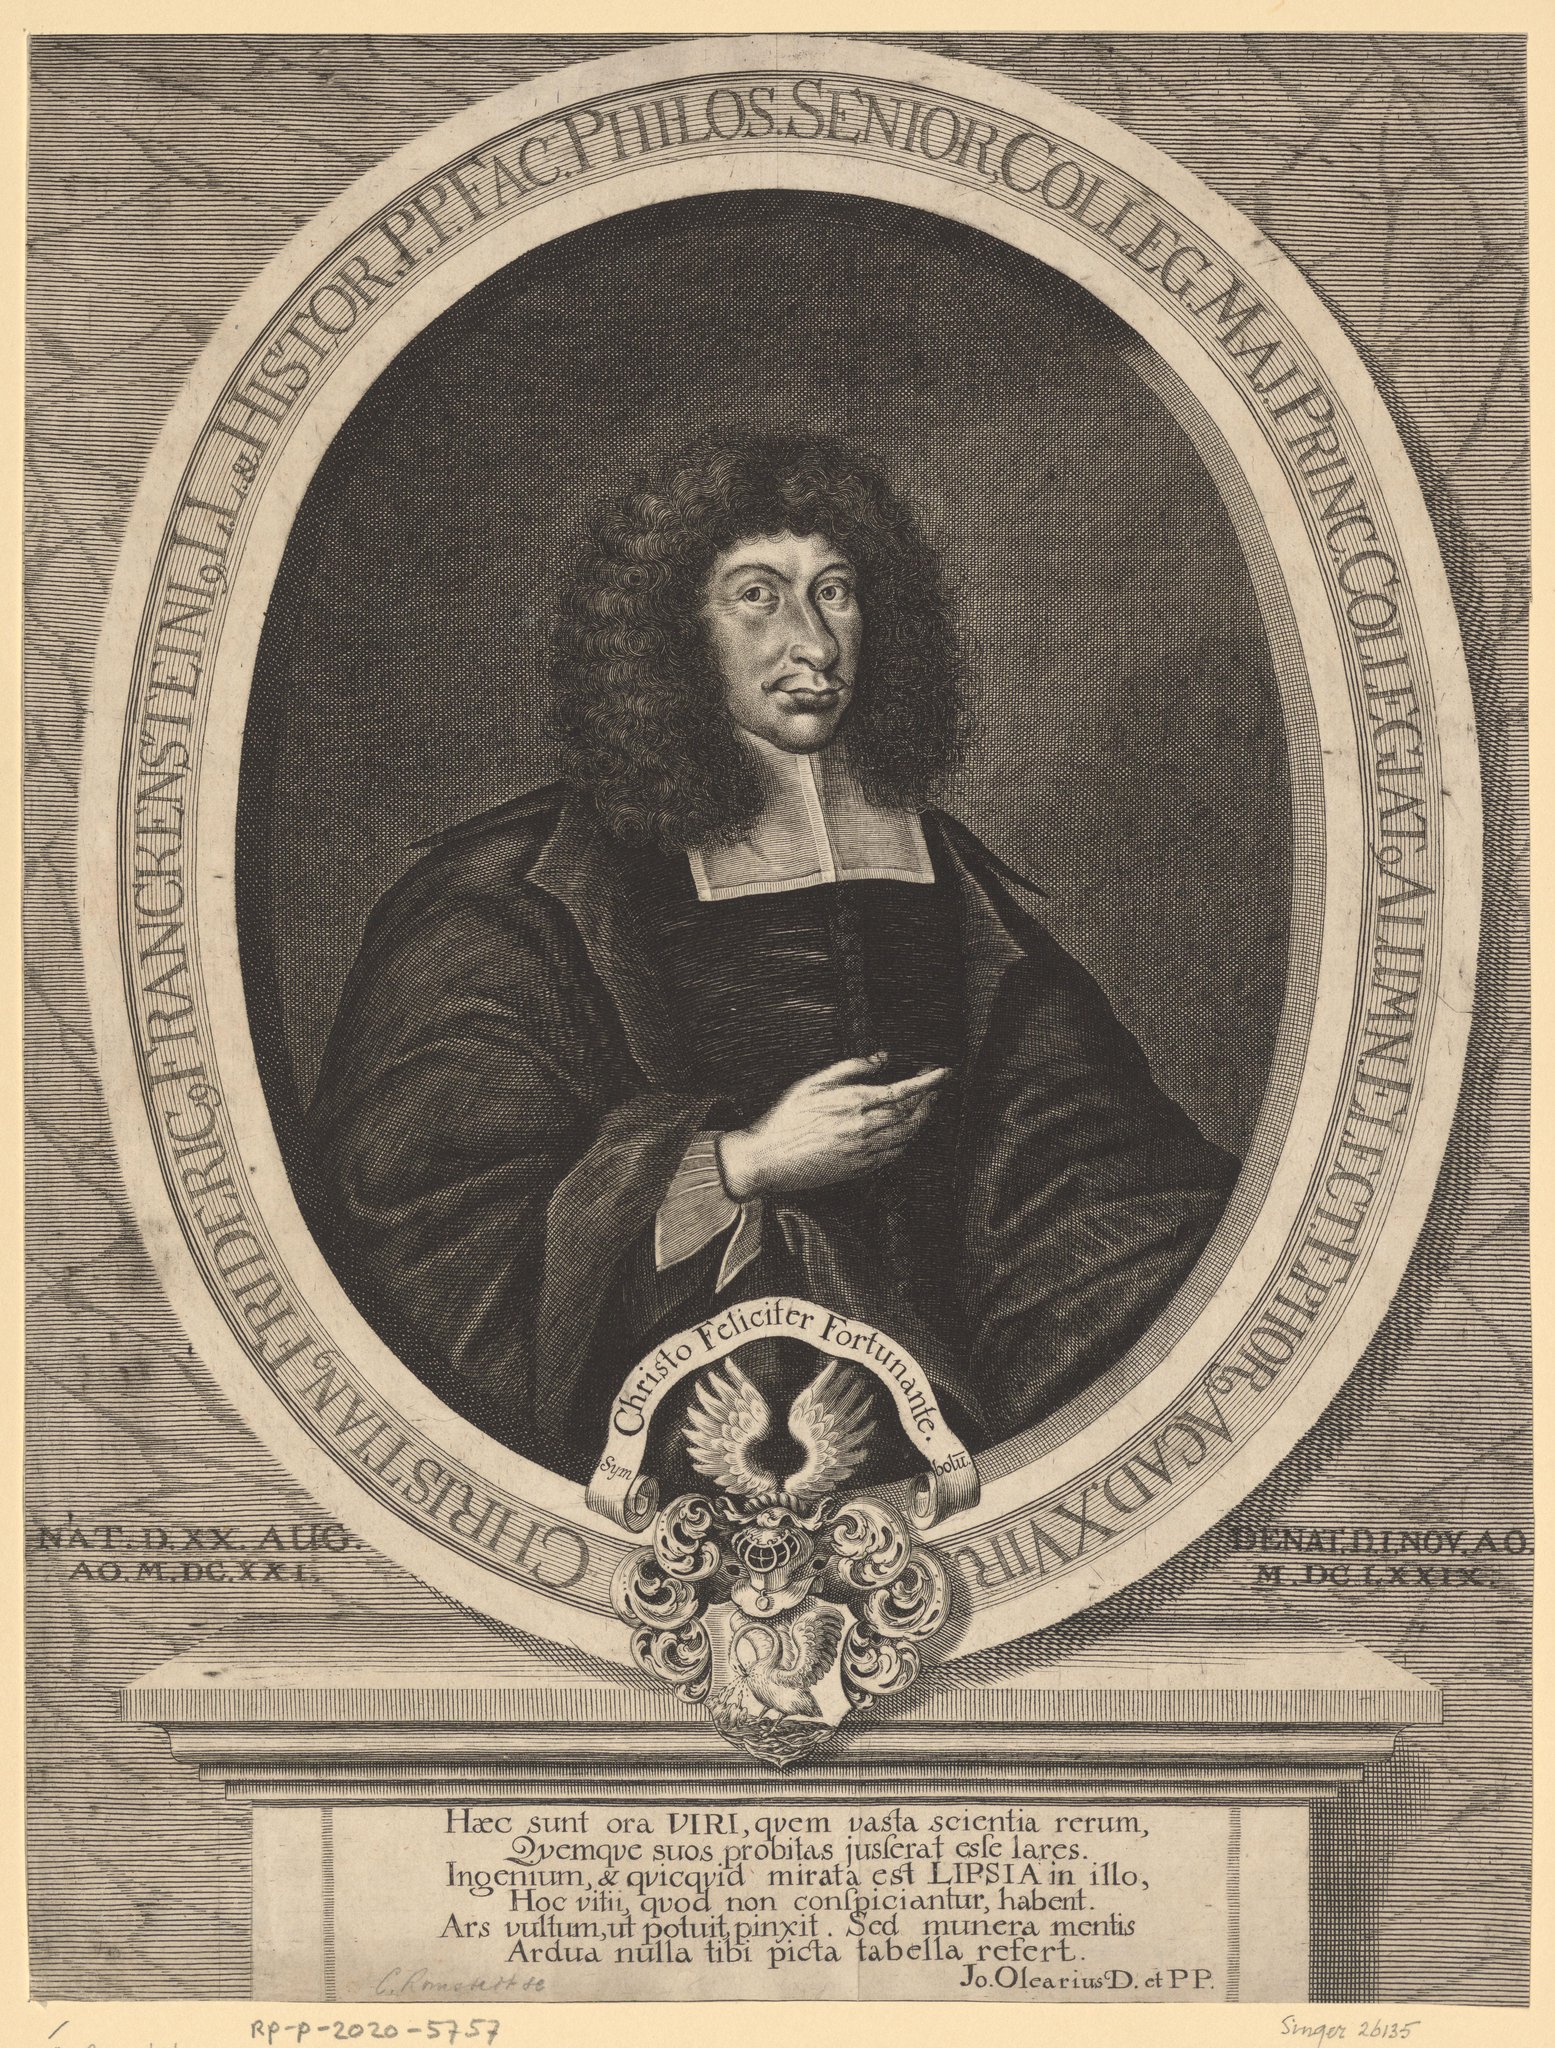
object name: print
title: Portret van Christian Friedrich Franckenstein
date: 1679-1721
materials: paper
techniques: engraving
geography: germany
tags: ornament ~ medallion, historical persons, armorial bearing, heraldry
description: Met zesregelig vers in het Latijn onder het portret.